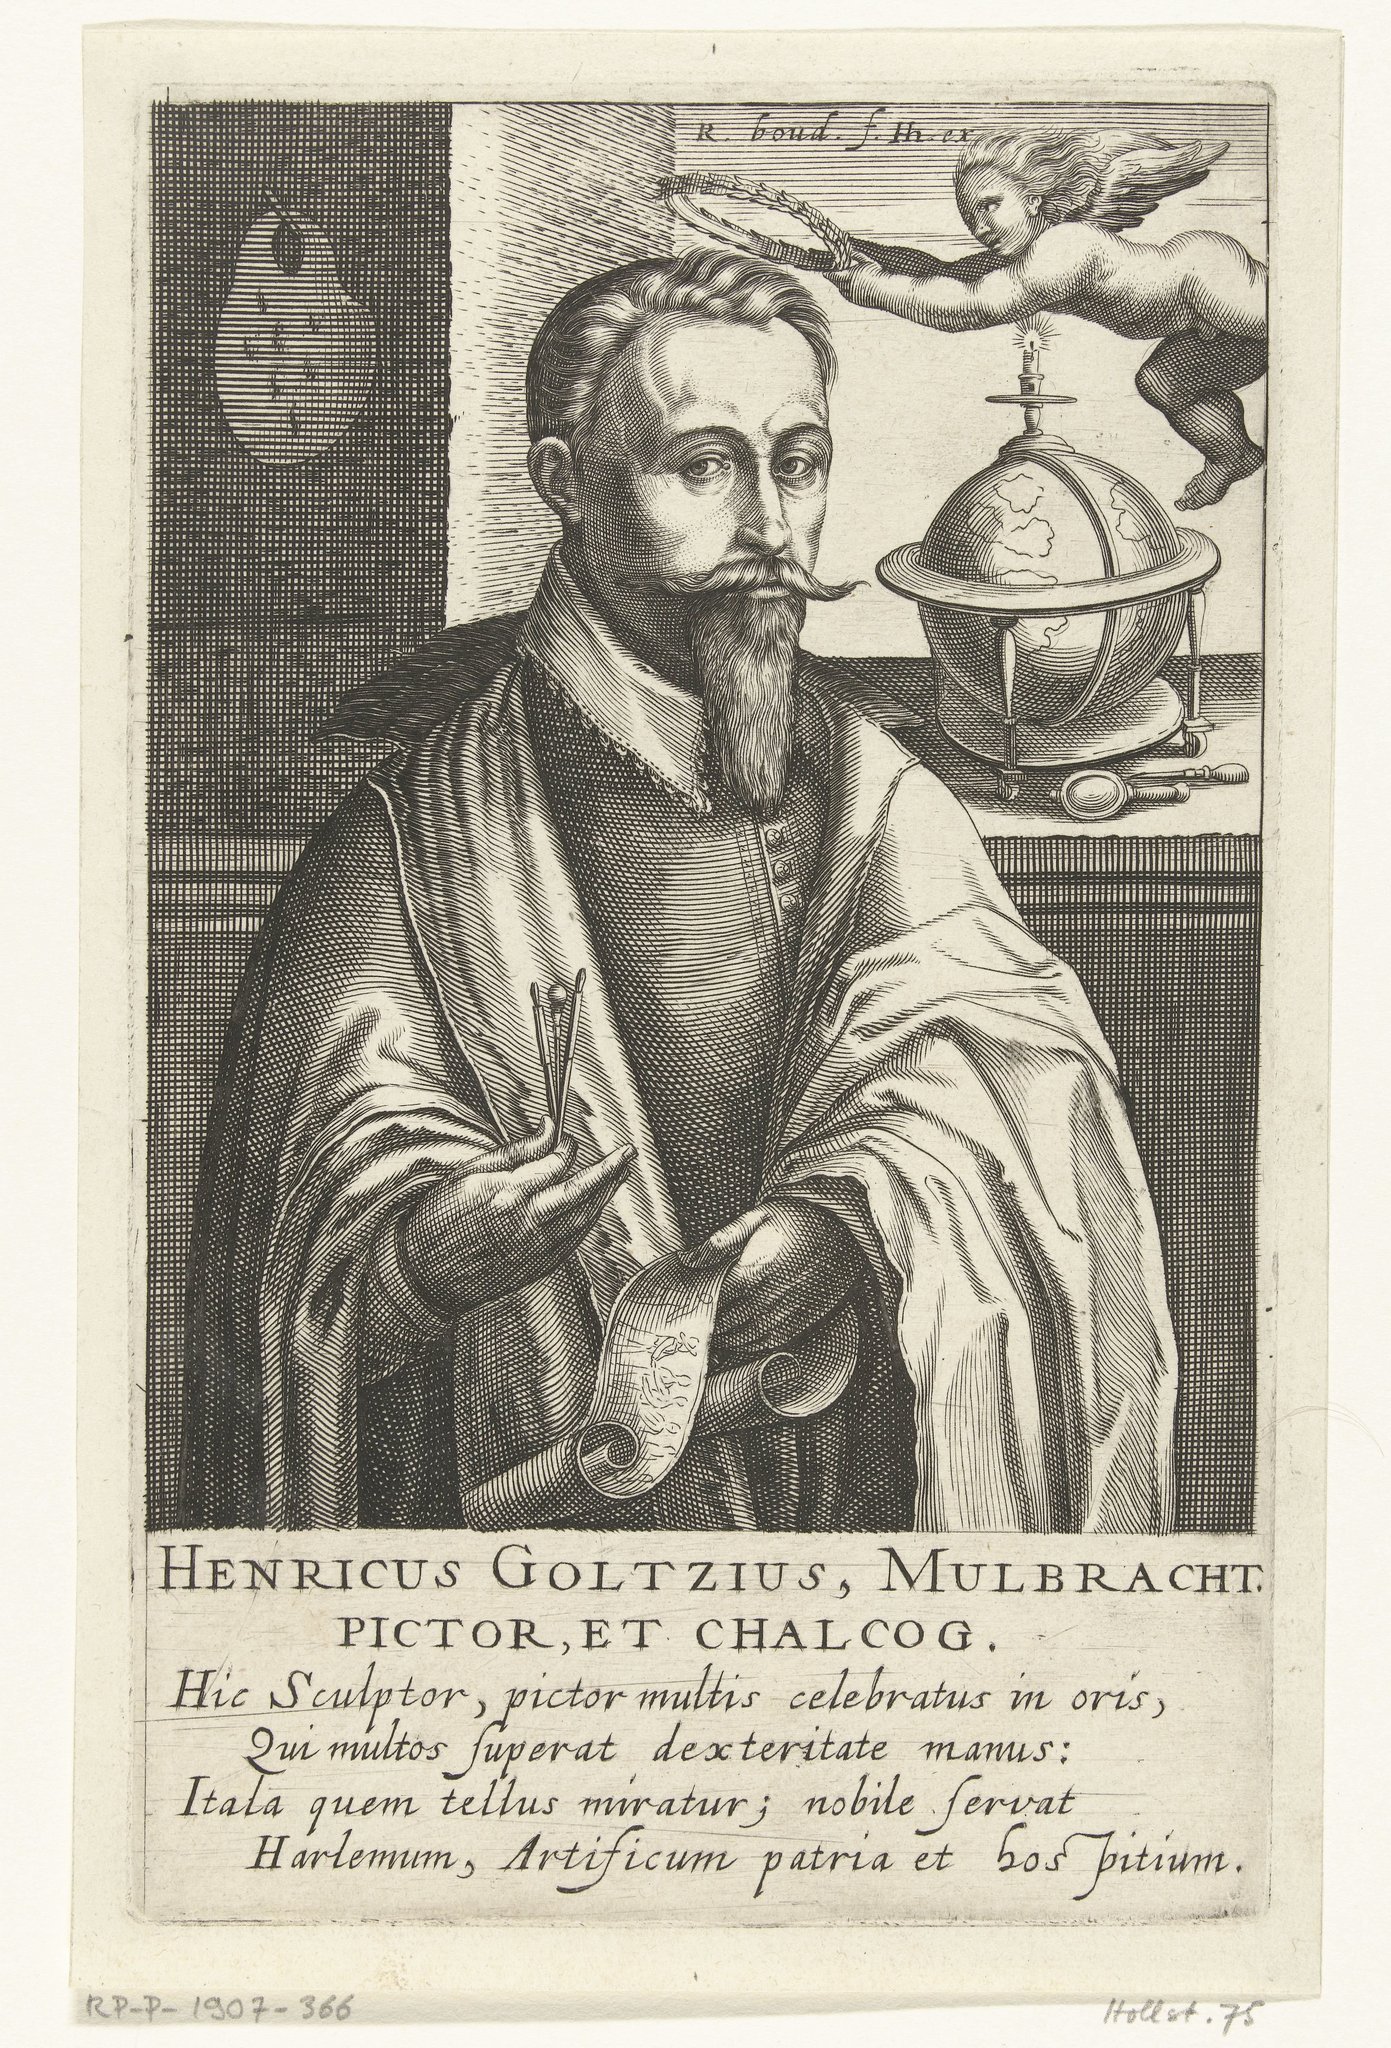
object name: print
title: Portret van Hendrik Goltzius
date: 1591-1659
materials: paper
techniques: engraving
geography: northern netherlands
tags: engraver, etcher, portrait, self-portrait of painter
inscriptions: collector's mark: Lugt 2228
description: Portret van de schilder en graveur Hendrick Goltzius. Van voren gezien. Een putto houdt hem een lauwerkrans boven het hoofd. Achter hem aan de muur hangt een palet. Rechtsachter in een vensterbank een globe.